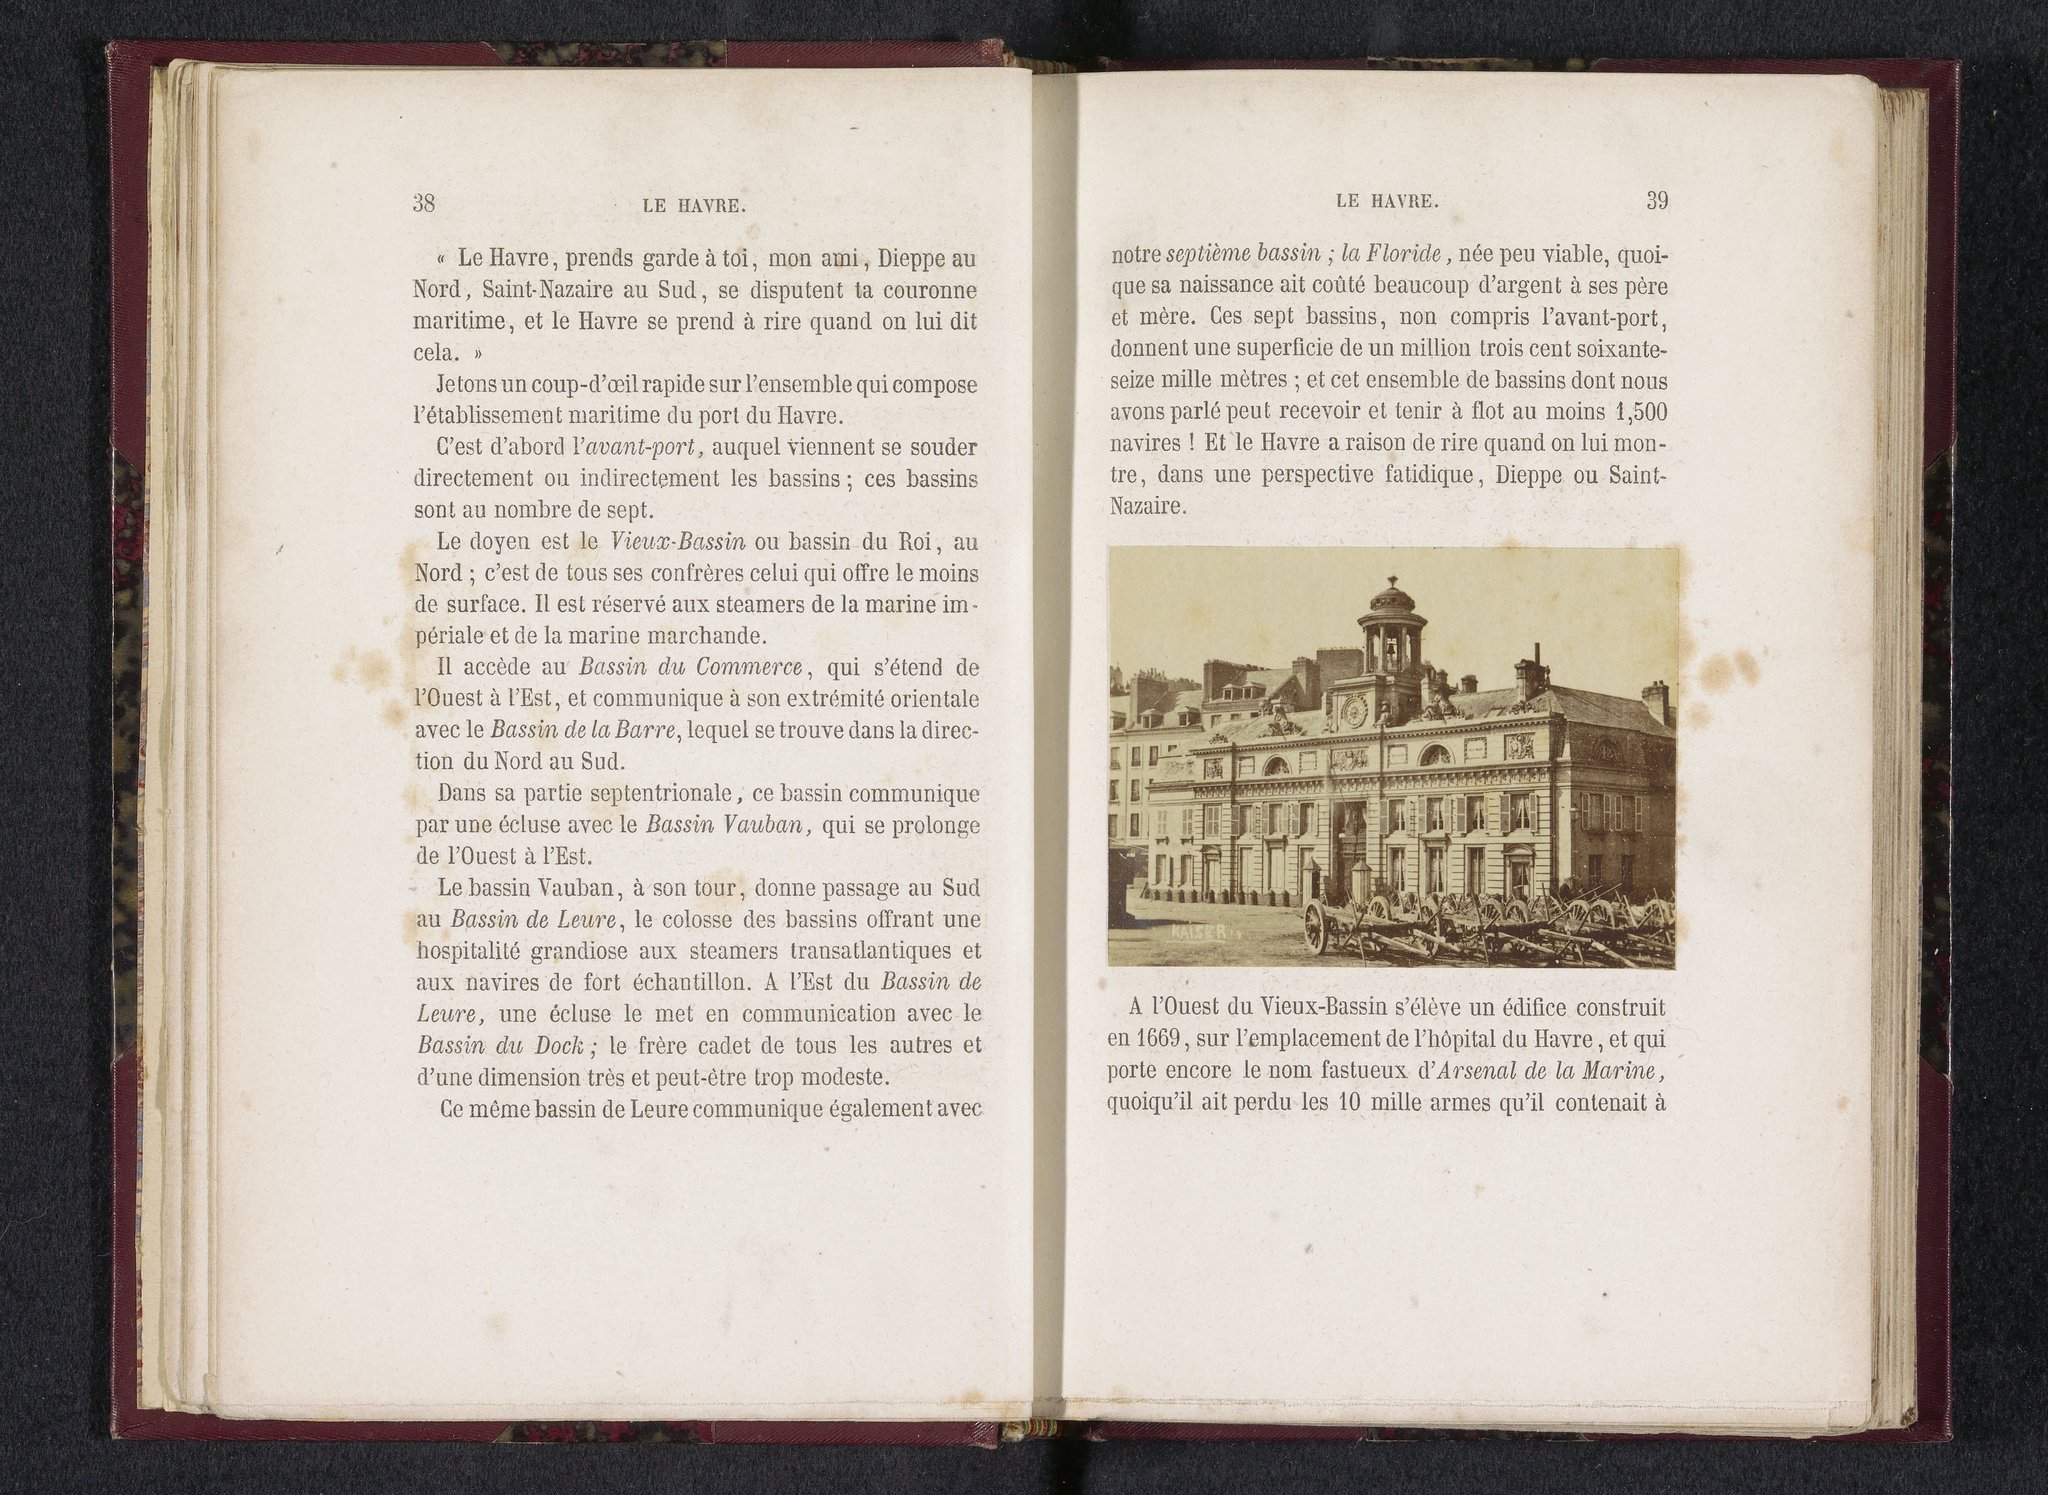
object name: photograph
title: Gezicht op het arsenaal in Le Havre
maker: kaiser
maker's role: fotograaf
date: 1850-1860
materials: photographic support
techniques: albumen print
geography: le havre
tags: ammunition store, arsenal, le havre